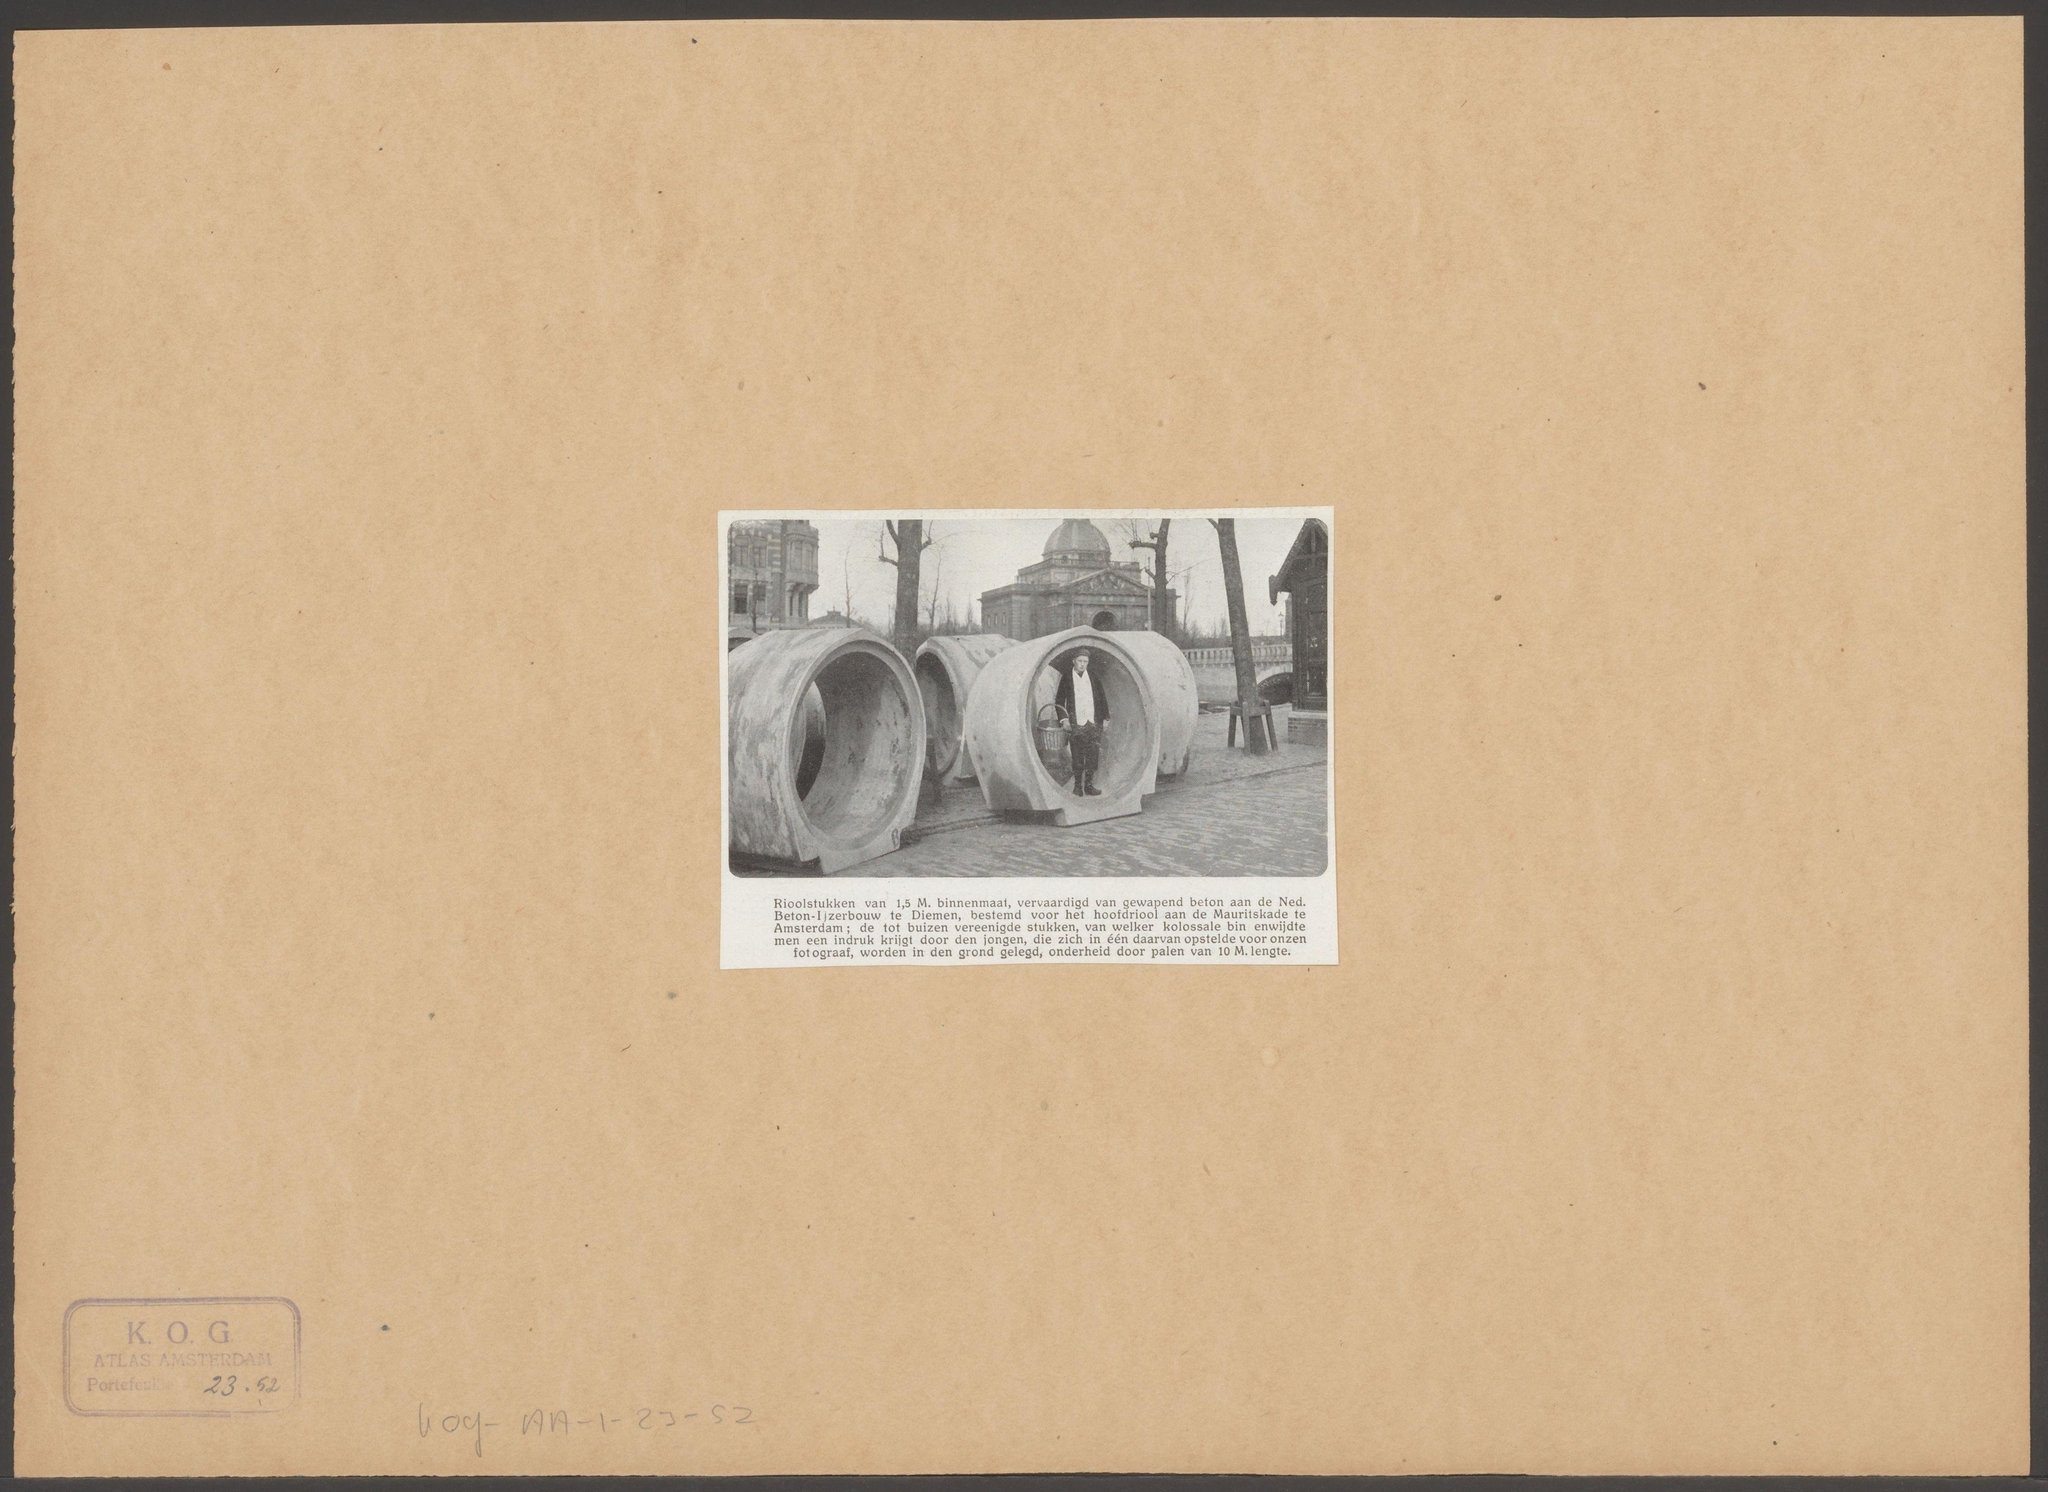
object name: photomechanical print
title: Man in een stuk van een betonnen rioolbuis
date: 1906-1912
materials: paper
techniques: letterpress printing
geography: amsterdam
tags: sewers, reinforced concrete ~ building material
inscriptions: collector's mark: Lugt 1641b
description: Onderwerpsrubriek binnen de Atlas Amsterdam: Gemeentebedrijven.